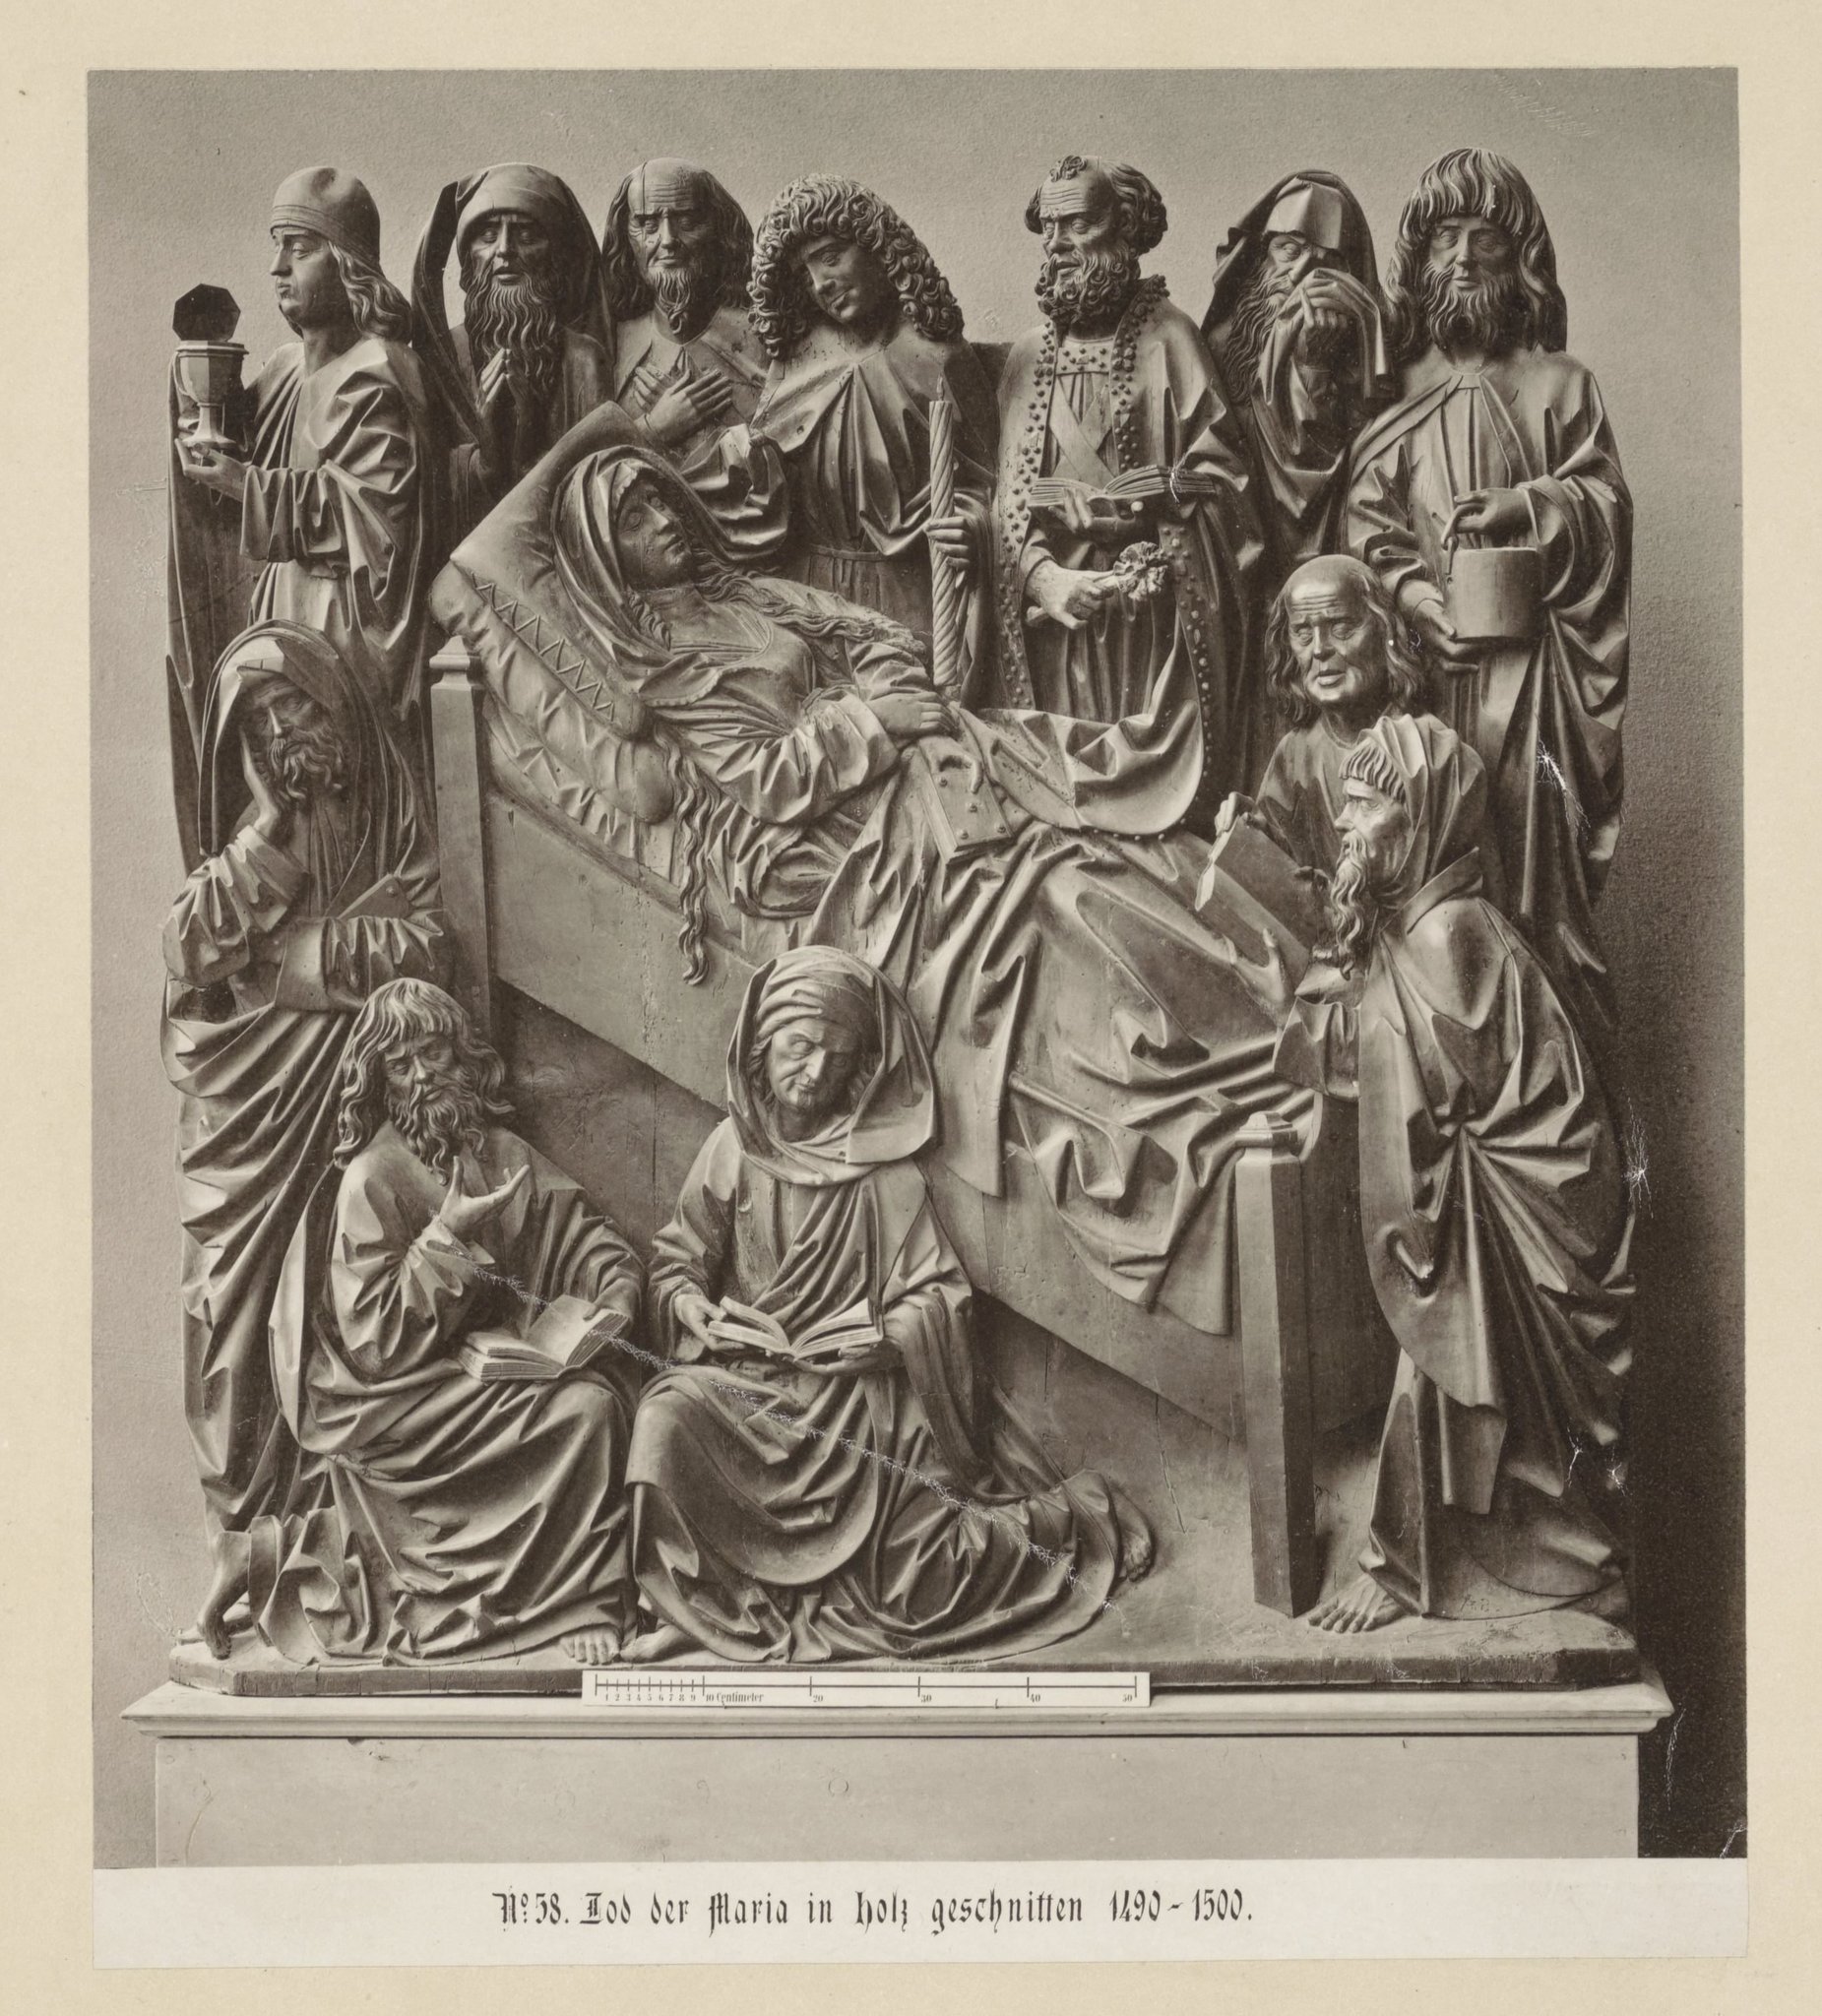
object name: photomechanical print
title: Reliëf van de dood van Maria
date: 1869-1887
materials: cardboard, paper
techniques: photograph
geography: munich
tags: piece of sculpture, reproduction of a piece of sculpture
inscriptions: check stamp: ‘Bayerisches National-Museum’, number: ‘No. 58.’, collector's mark: Lugt 3937, inscription: ‘Bayerisches National-Museum’